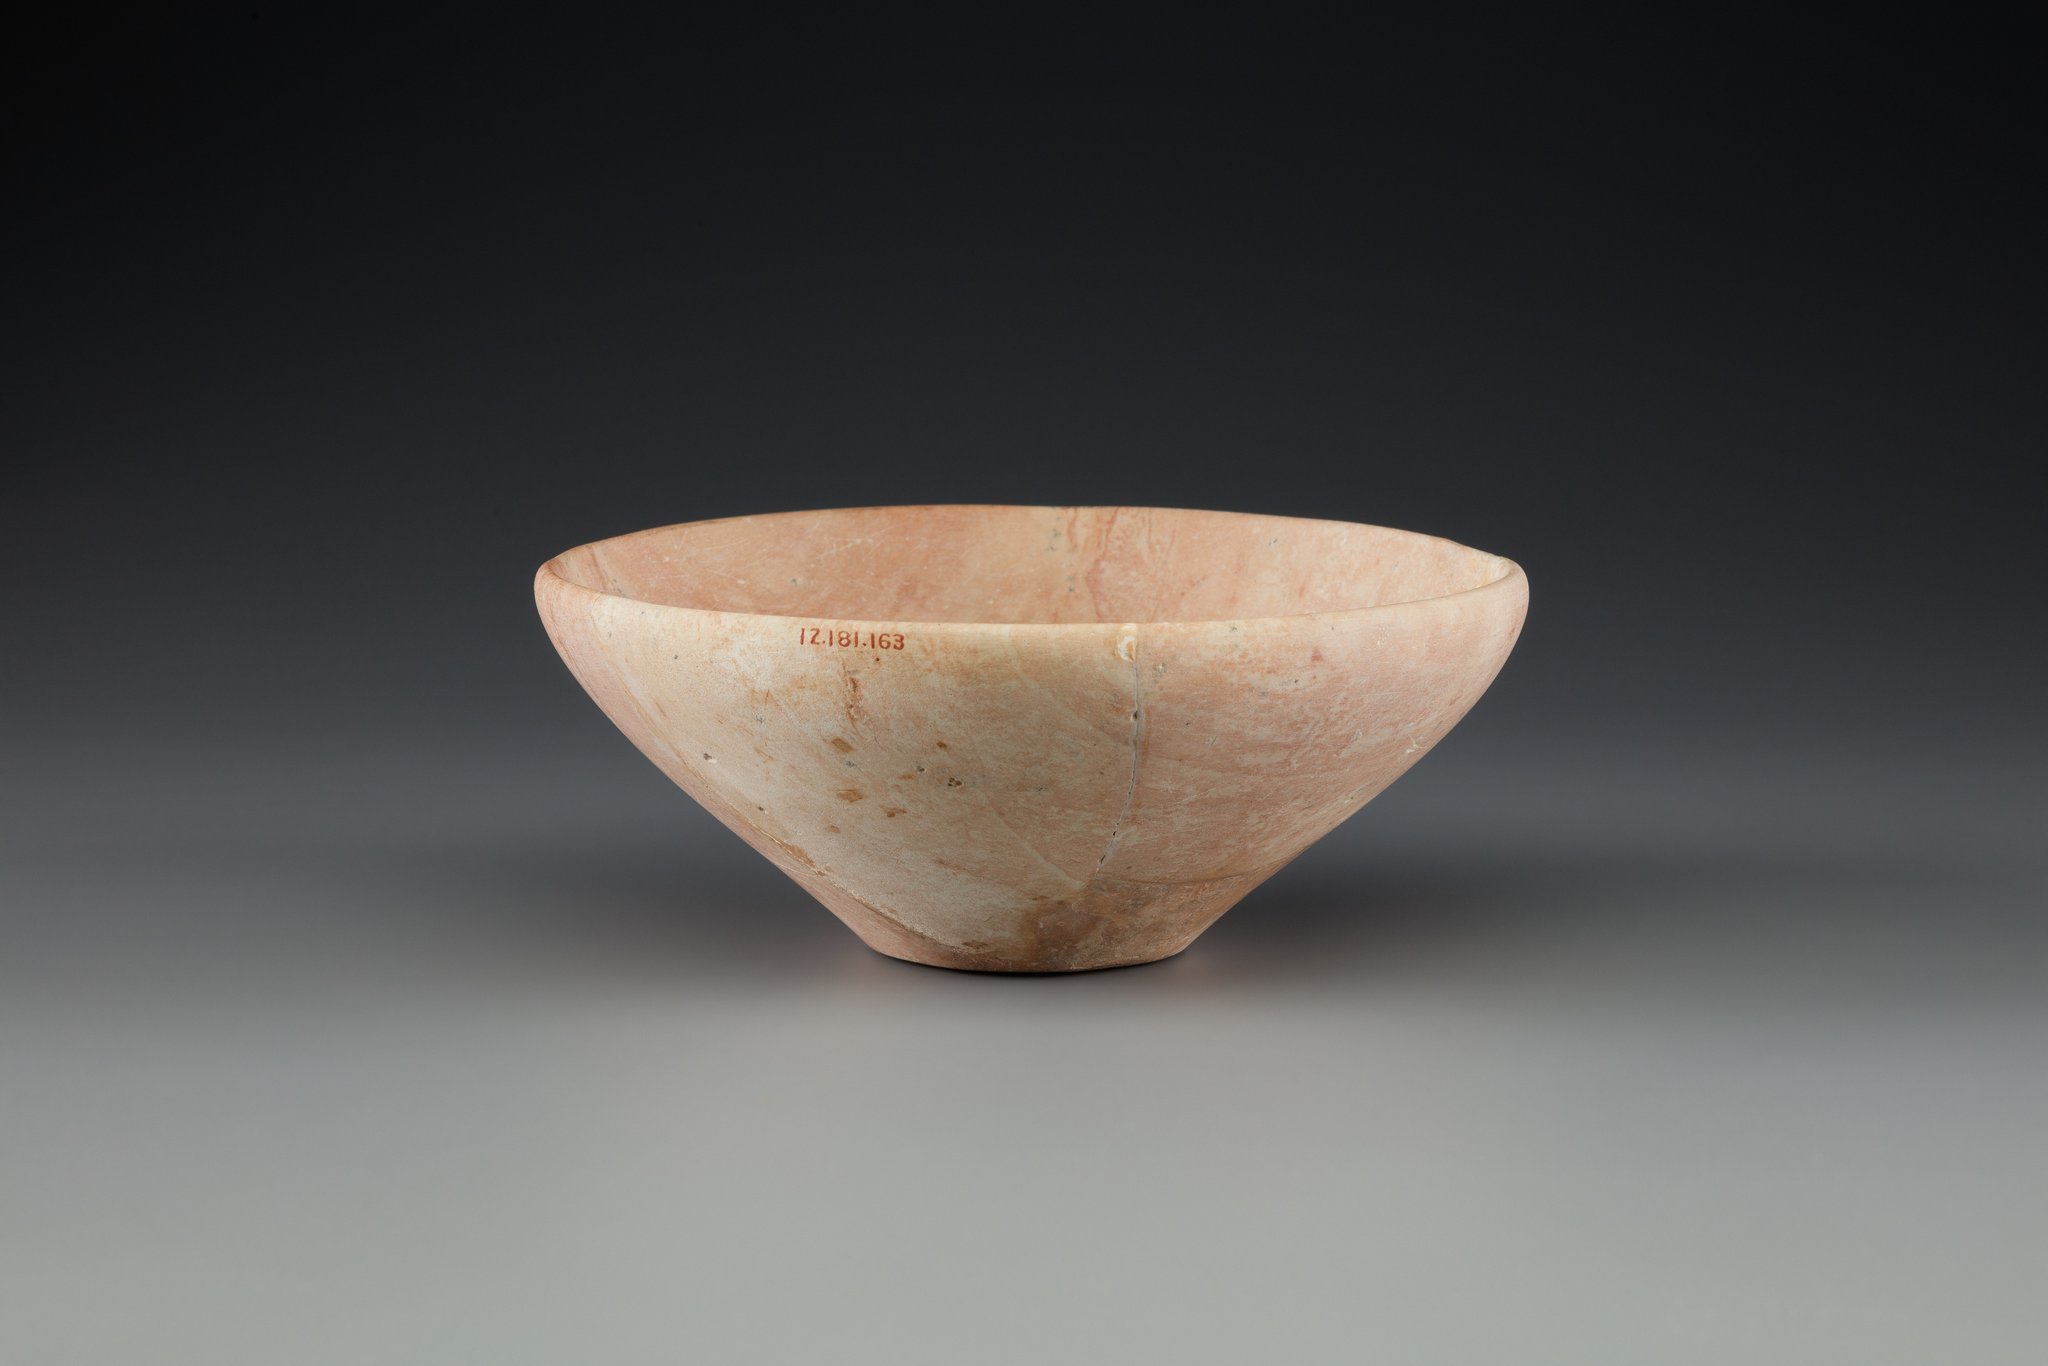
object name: bowl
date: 3100-2649 BCE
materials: stone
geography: egypt